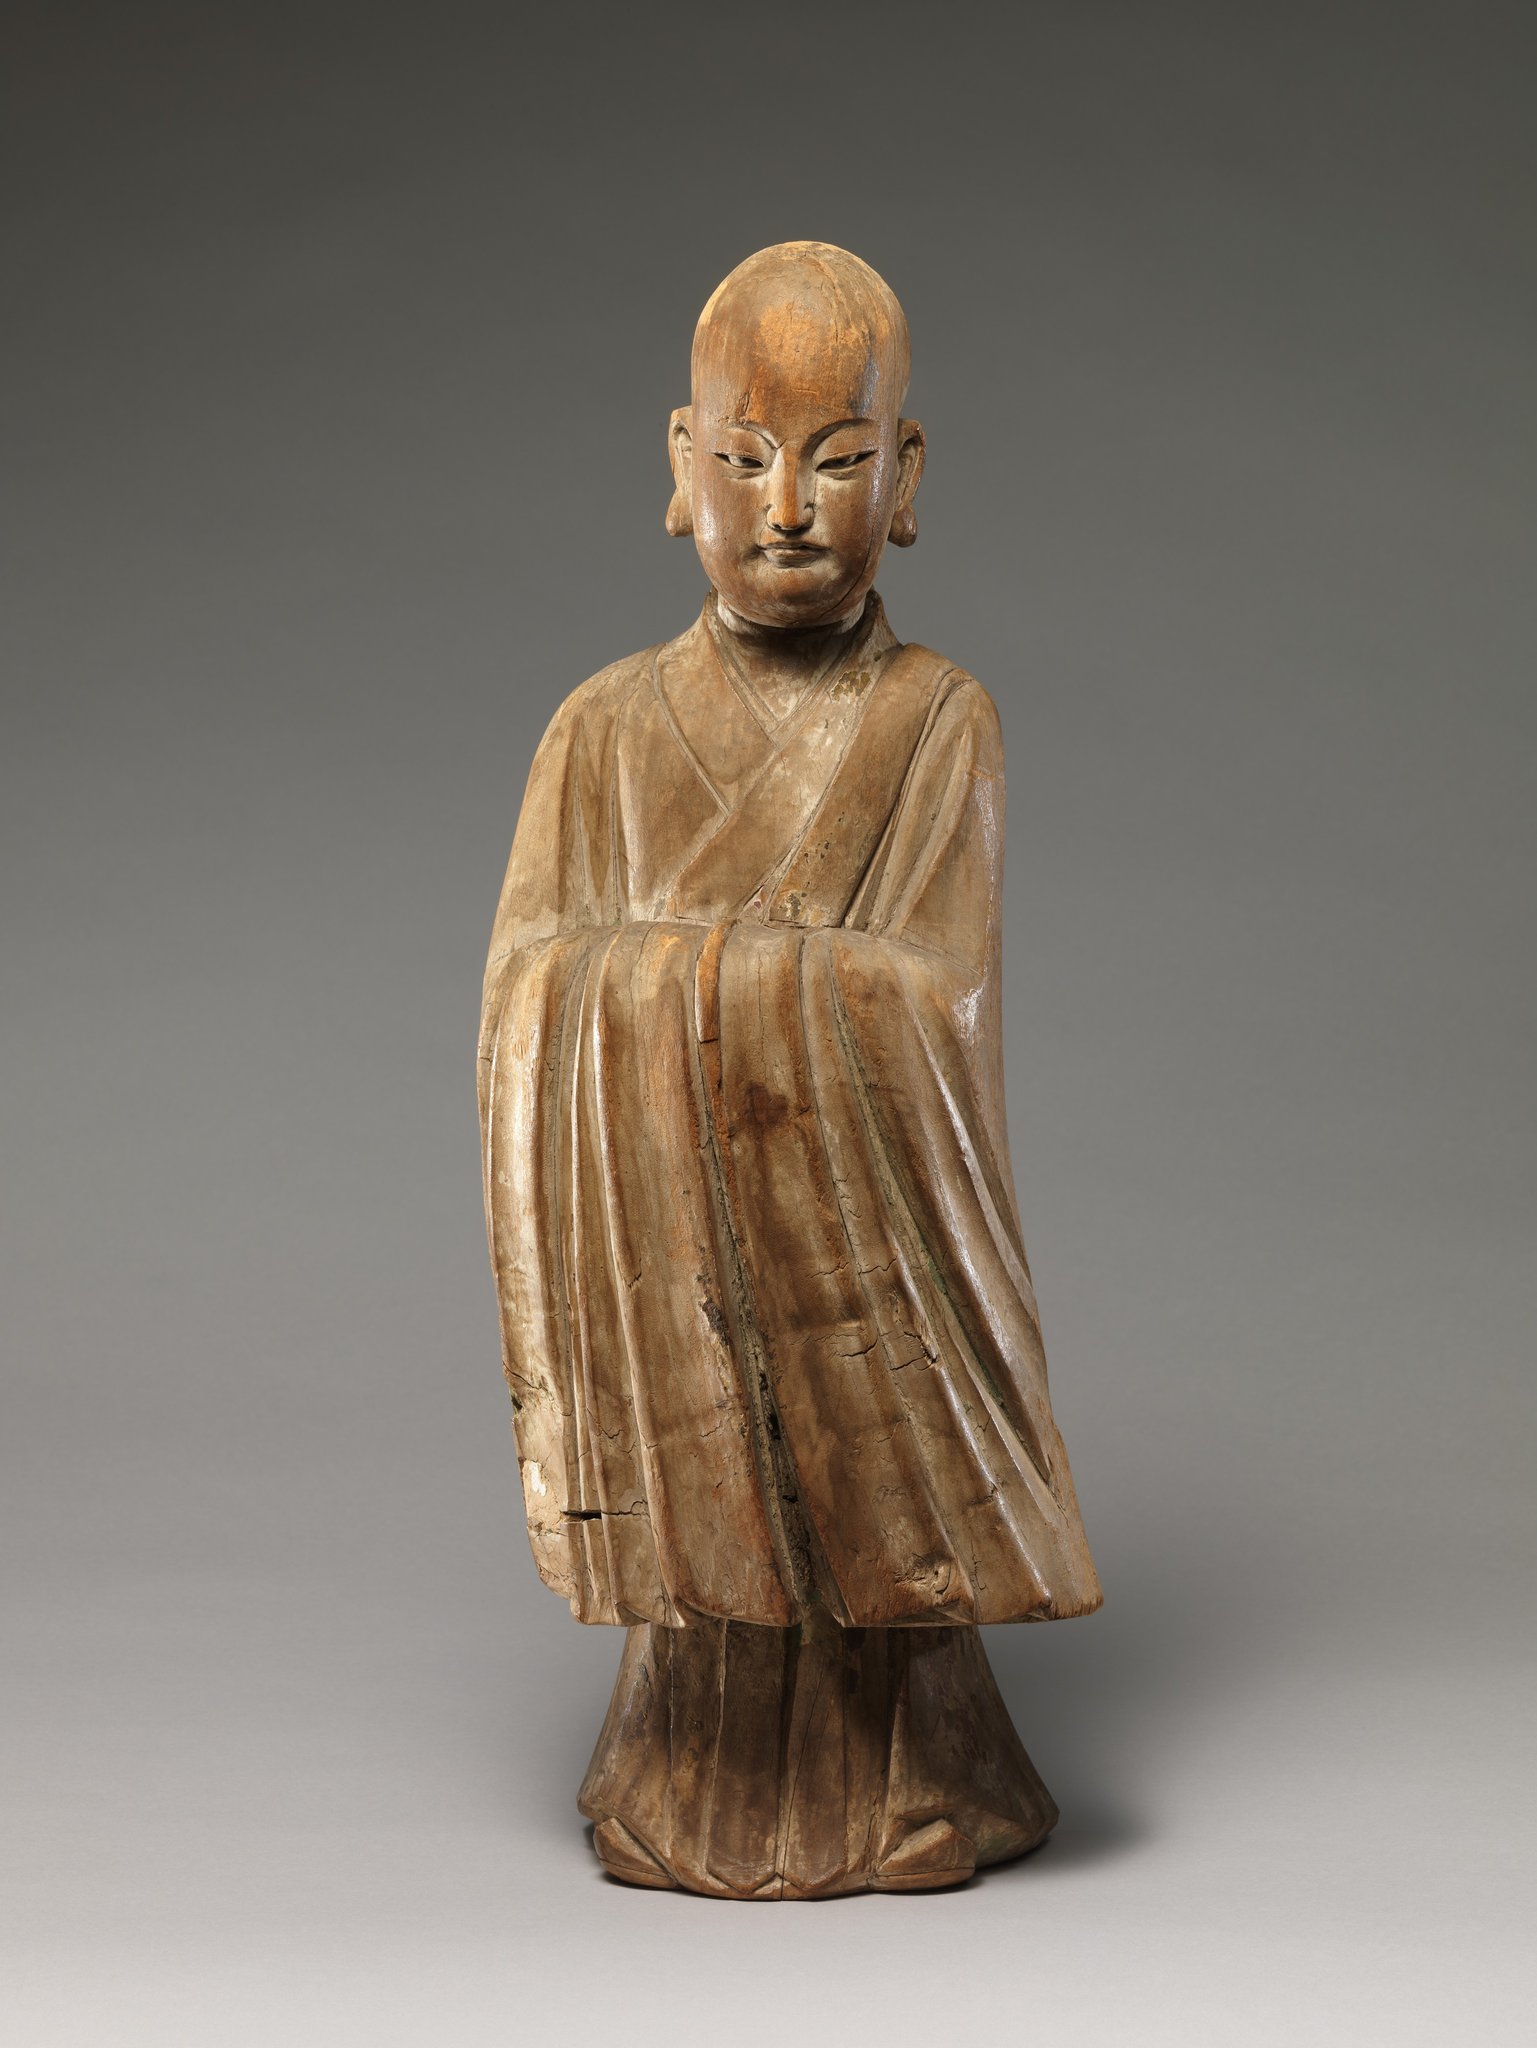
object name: figure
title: Arhat (Luohan)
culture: chinese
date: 1501-1700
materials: pigment, wood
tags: men,buddhism